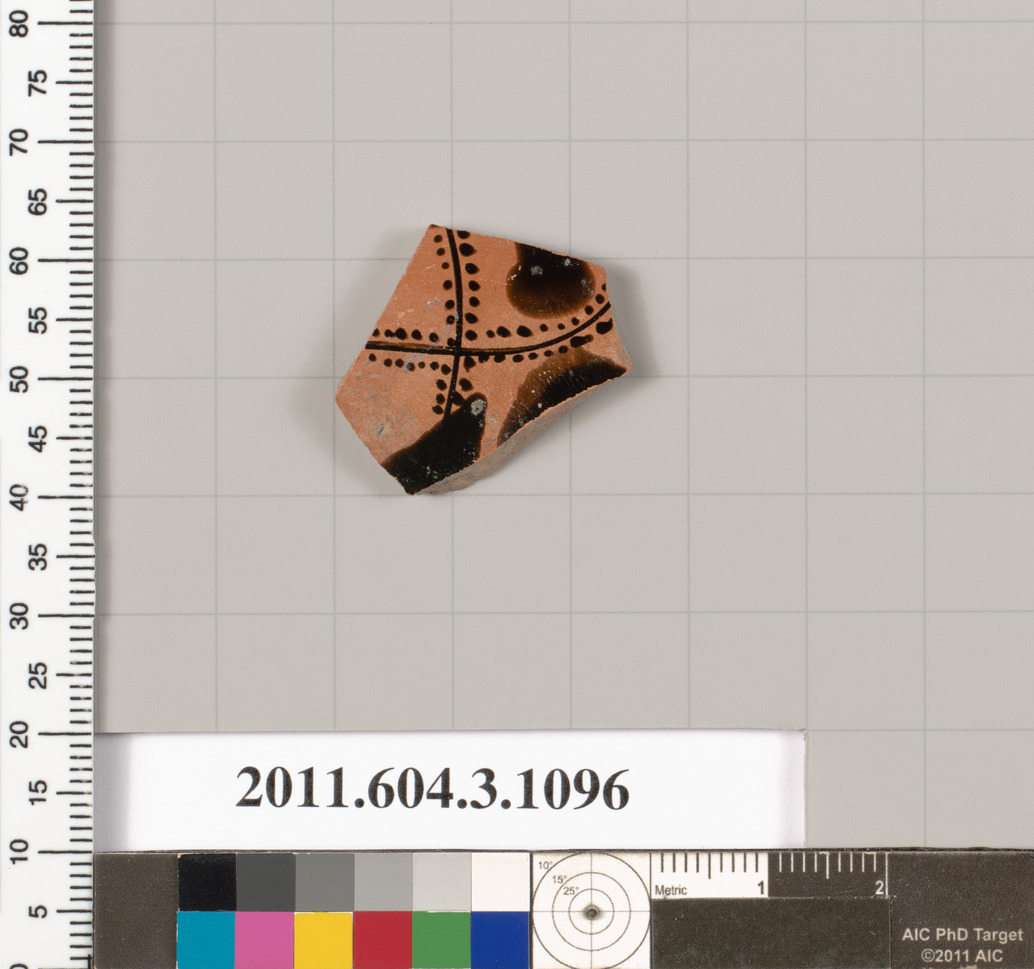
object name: mastoid fragment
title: Terracotta fragment of a mastoid (drinking cup with narrow base)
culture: greek, attic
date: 534-468 BCE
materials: terracotta